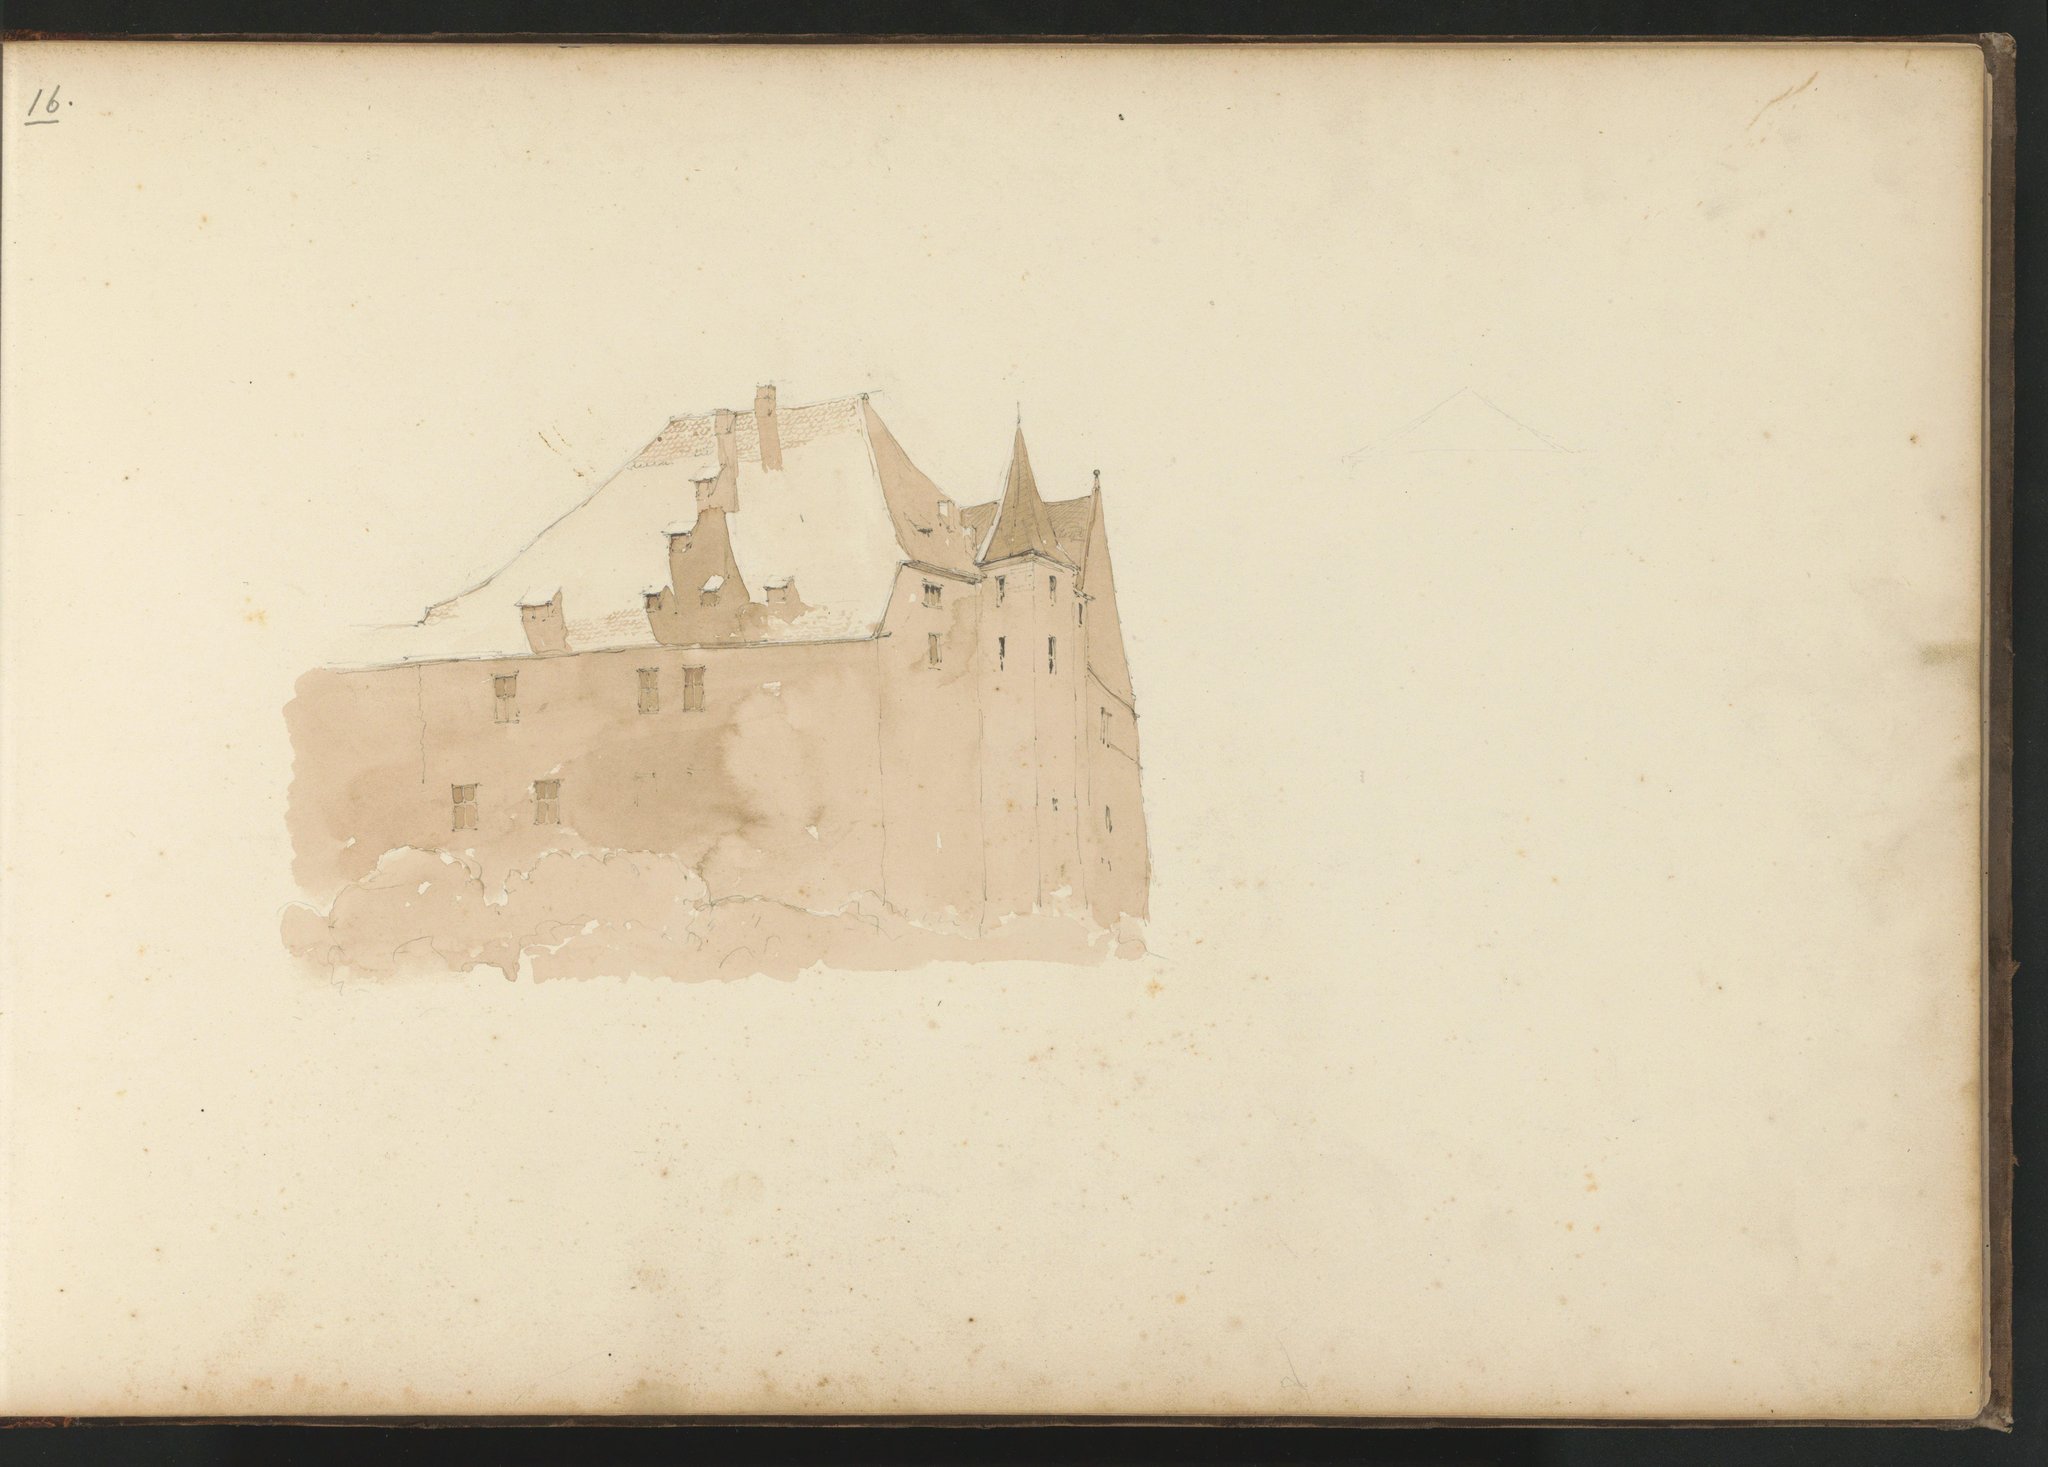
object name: sketchbook leaf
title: Gebouw met een toren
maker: kasparus karsen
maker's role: draughtsman, painter, print maker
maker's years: 1810-1896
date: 1820-1896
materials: paper, pencil, watercolor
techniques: brush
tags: architecture, tower (of house or building)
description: Blad 16 recto uit een schetsboek met 68 bladen.